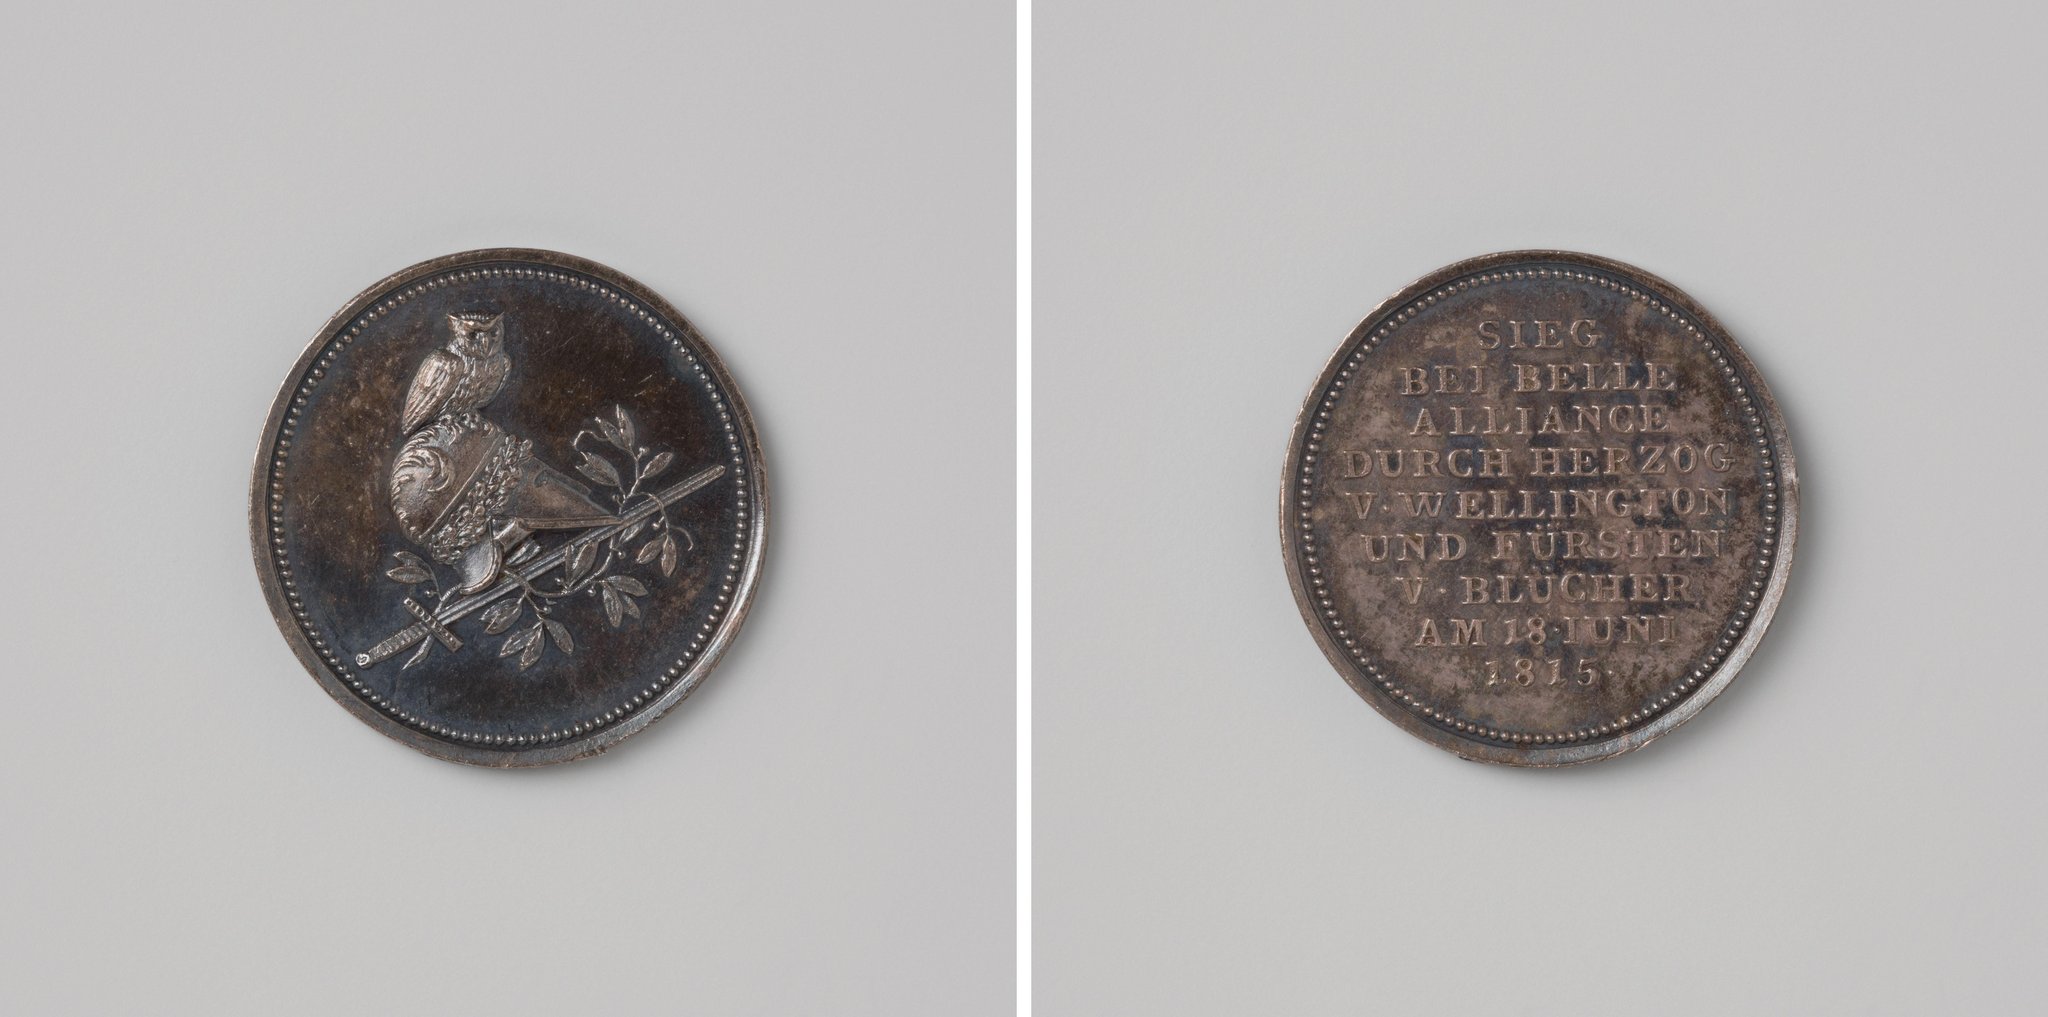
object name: history medal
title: Slag bij Waterloo, ter ere van de hertog van Wellington en Blucher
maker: Anonymous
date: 1815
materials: silver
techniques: striking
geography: germany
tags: walmer castle, arthur wellesley of wellington, waterloo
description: Zilveren penning. Voorzijde: uil zittend op met eikekrans omwonden helm, boven zwaard, waaromheen olijftak is gevlochten. Keerzijde: opschrift